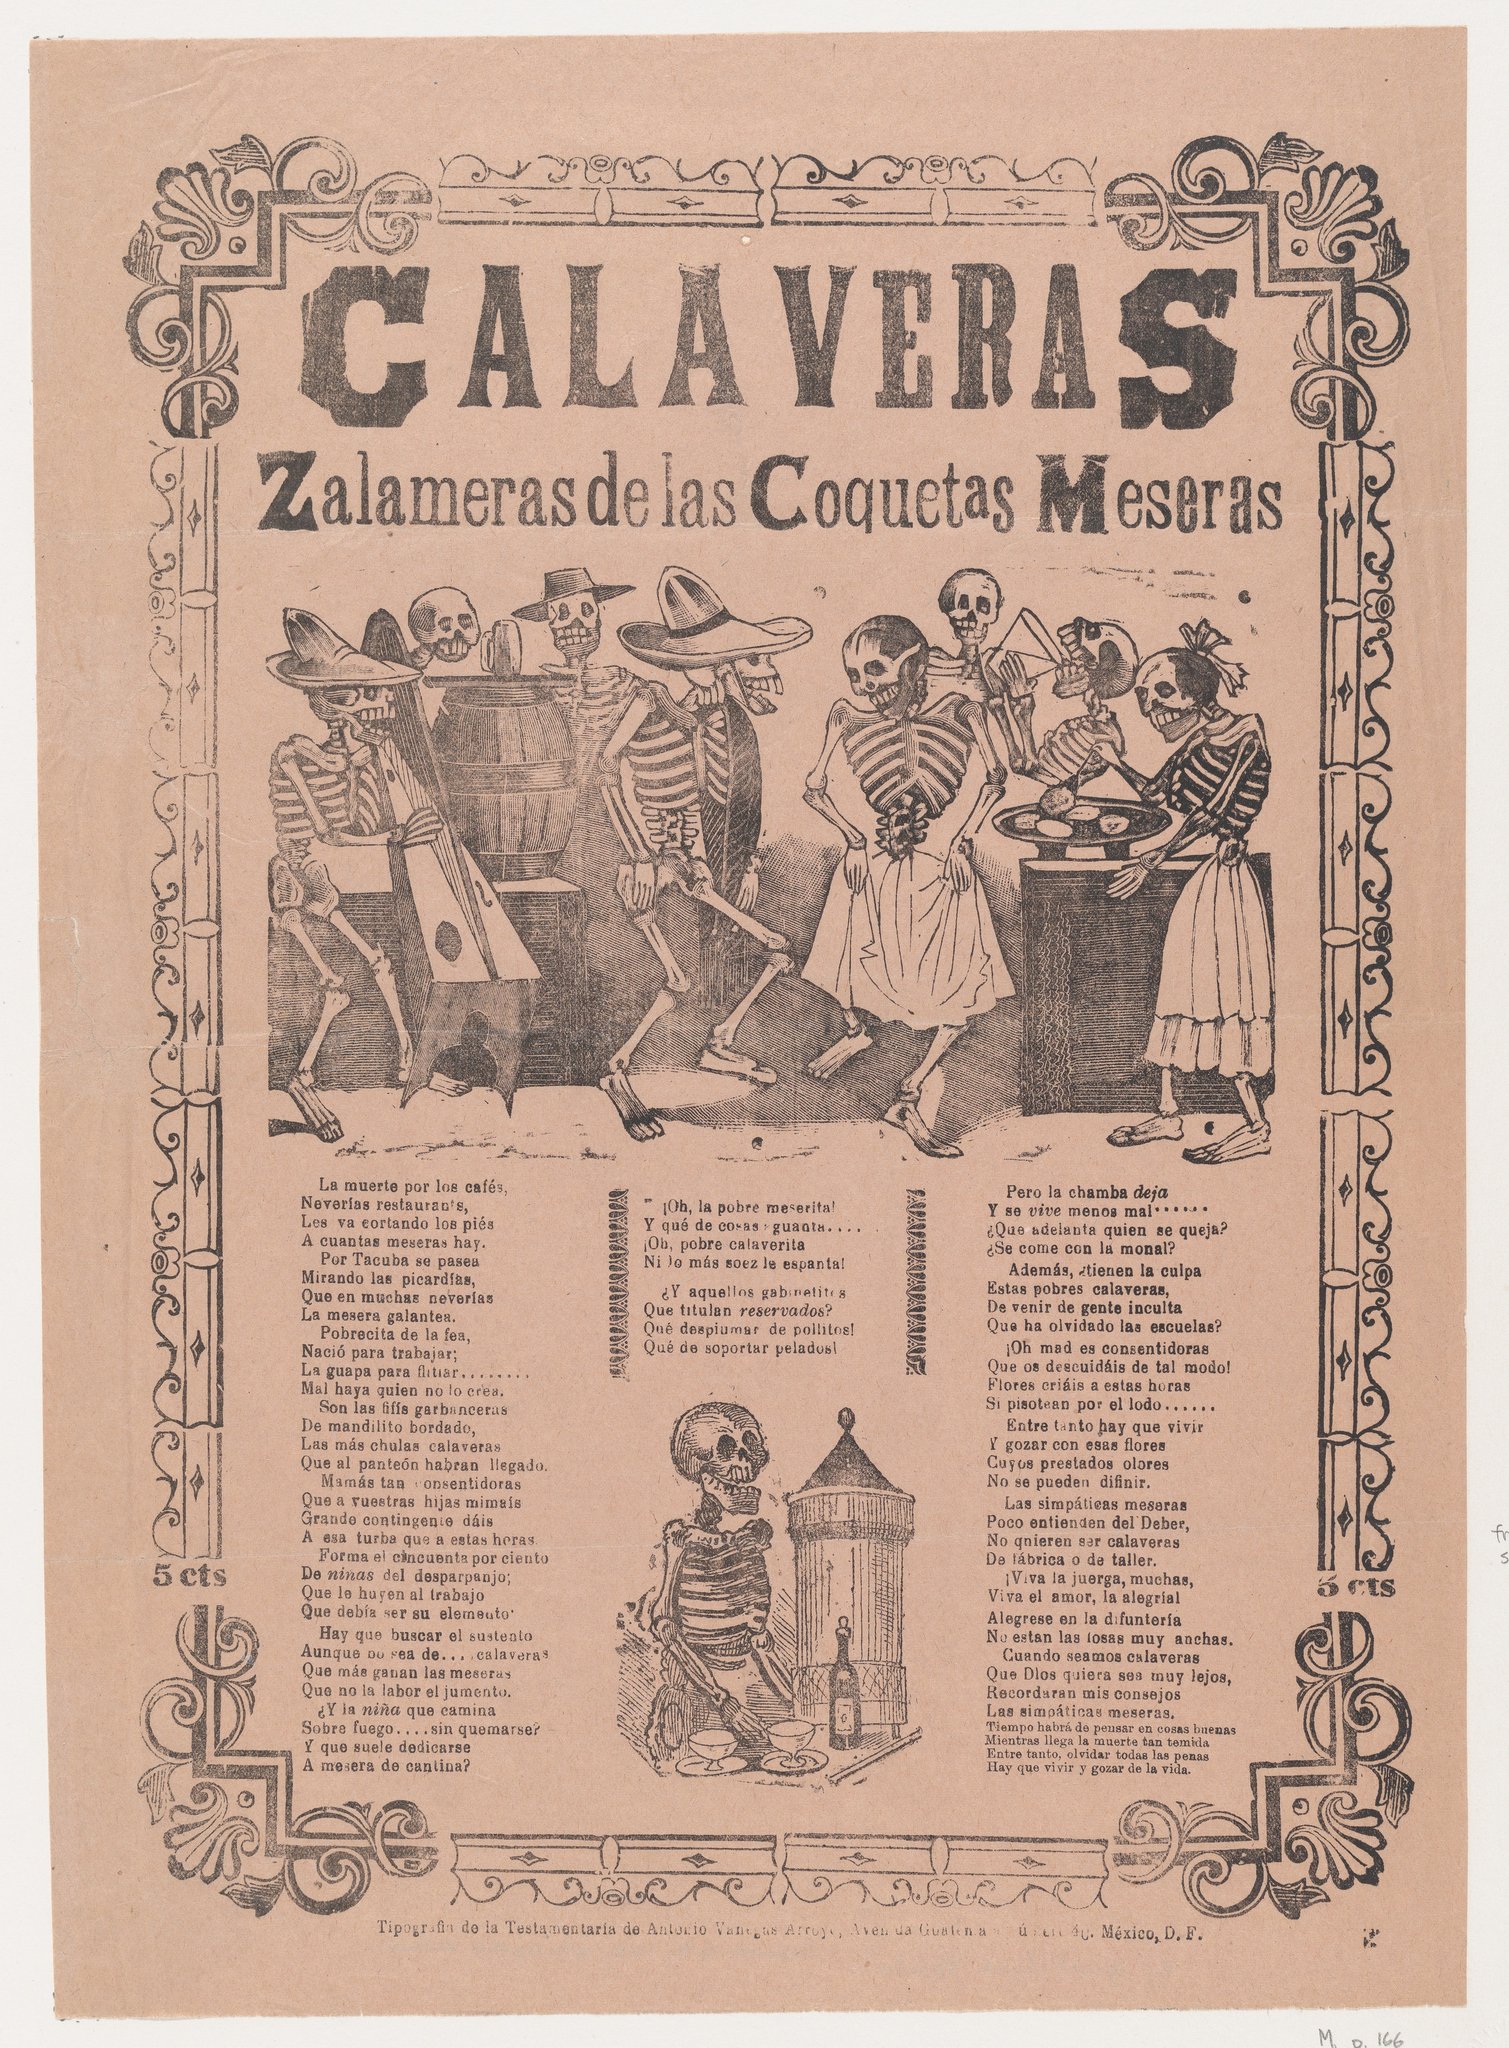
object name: print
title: Skeletons (calaveras) dancing and drinking, relating to the coquettish waitress, corrido in bottom section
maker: josé guadalupe posada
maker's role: artist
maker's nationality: mexican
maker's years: 1852-1913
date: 1892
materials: metal, paper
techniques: engraving, letterpress, lithography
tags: skeletons,dancing